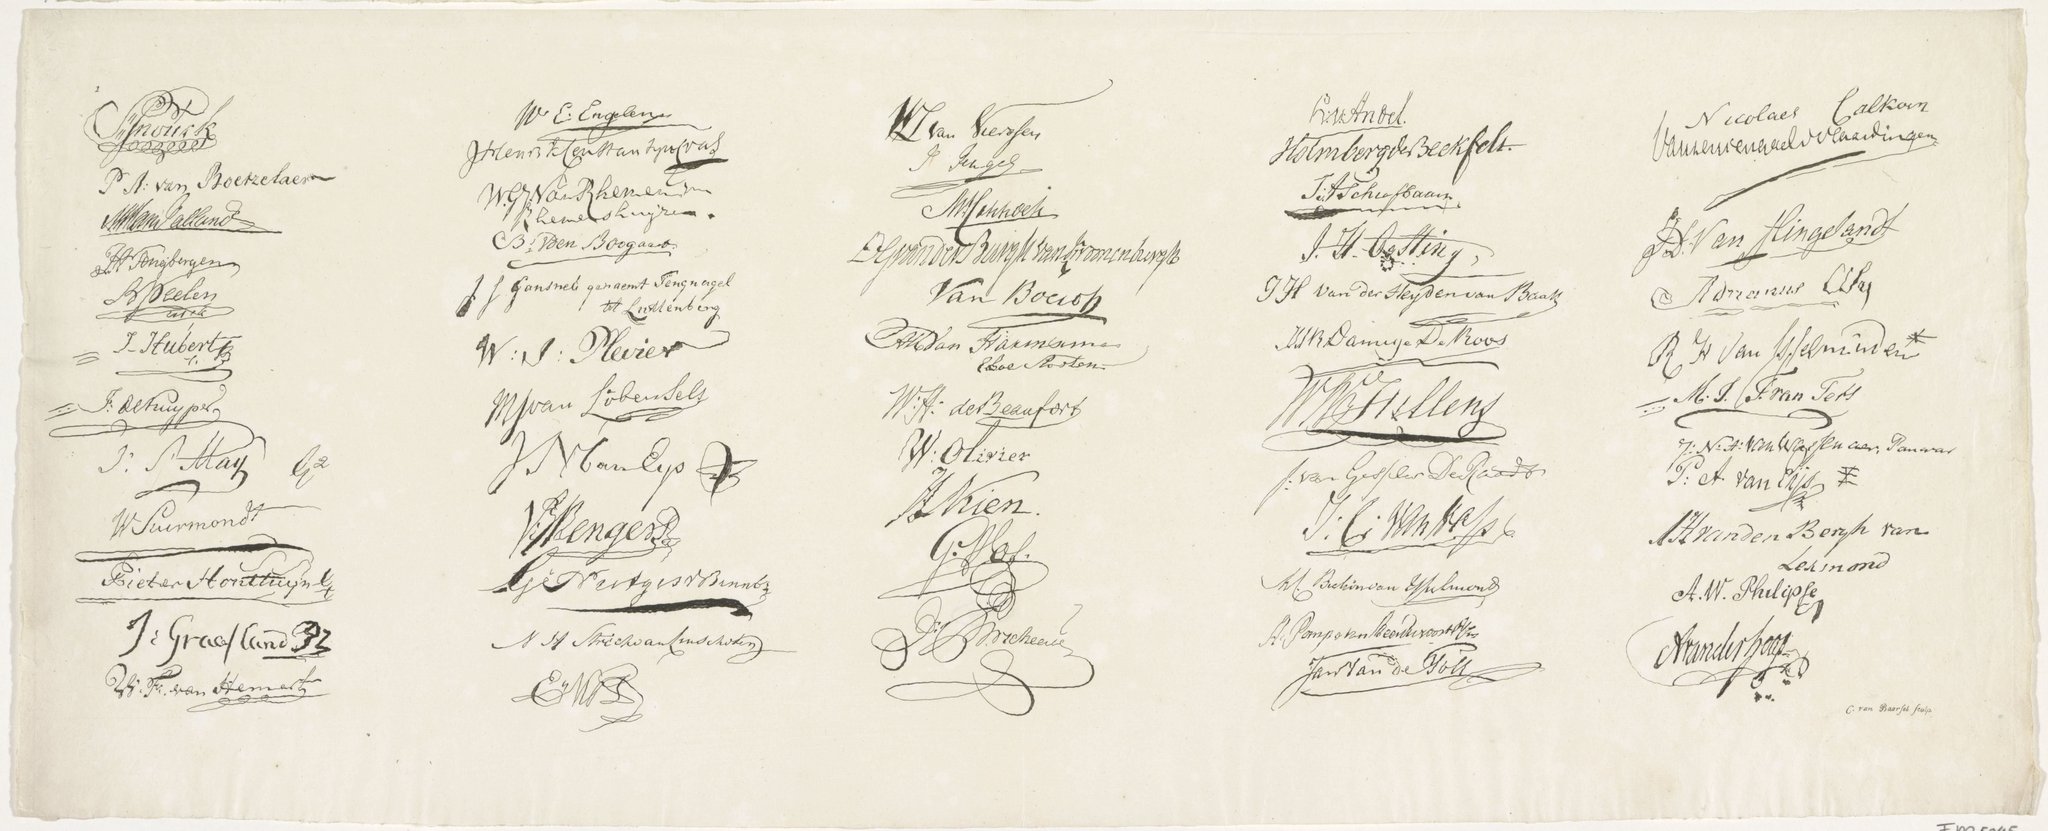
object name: print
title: Naamteekeningen der leden van de Vergadering der Aanzienlijken, ter goed- of afkeuring der Grondwet voor de Vereenigde Nederlanden. Gegraveerd naar de oorspronkelijke handteekeningen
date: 1814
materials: paper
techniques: etching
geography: netherlands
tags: the hague, berlin, william i of the netherlands, handwriting, written text, amsterdam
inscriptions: collector's mark: Lugt 2228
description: Blad nr. 1 uit de serie van negen bladen met in facsimile de handtekeningen van de leden van de Vergadering der Aanzienlijken bijeen ter onderhandeling over de nieuwe grondwet, te Amsterdam op 29 maart 1814.